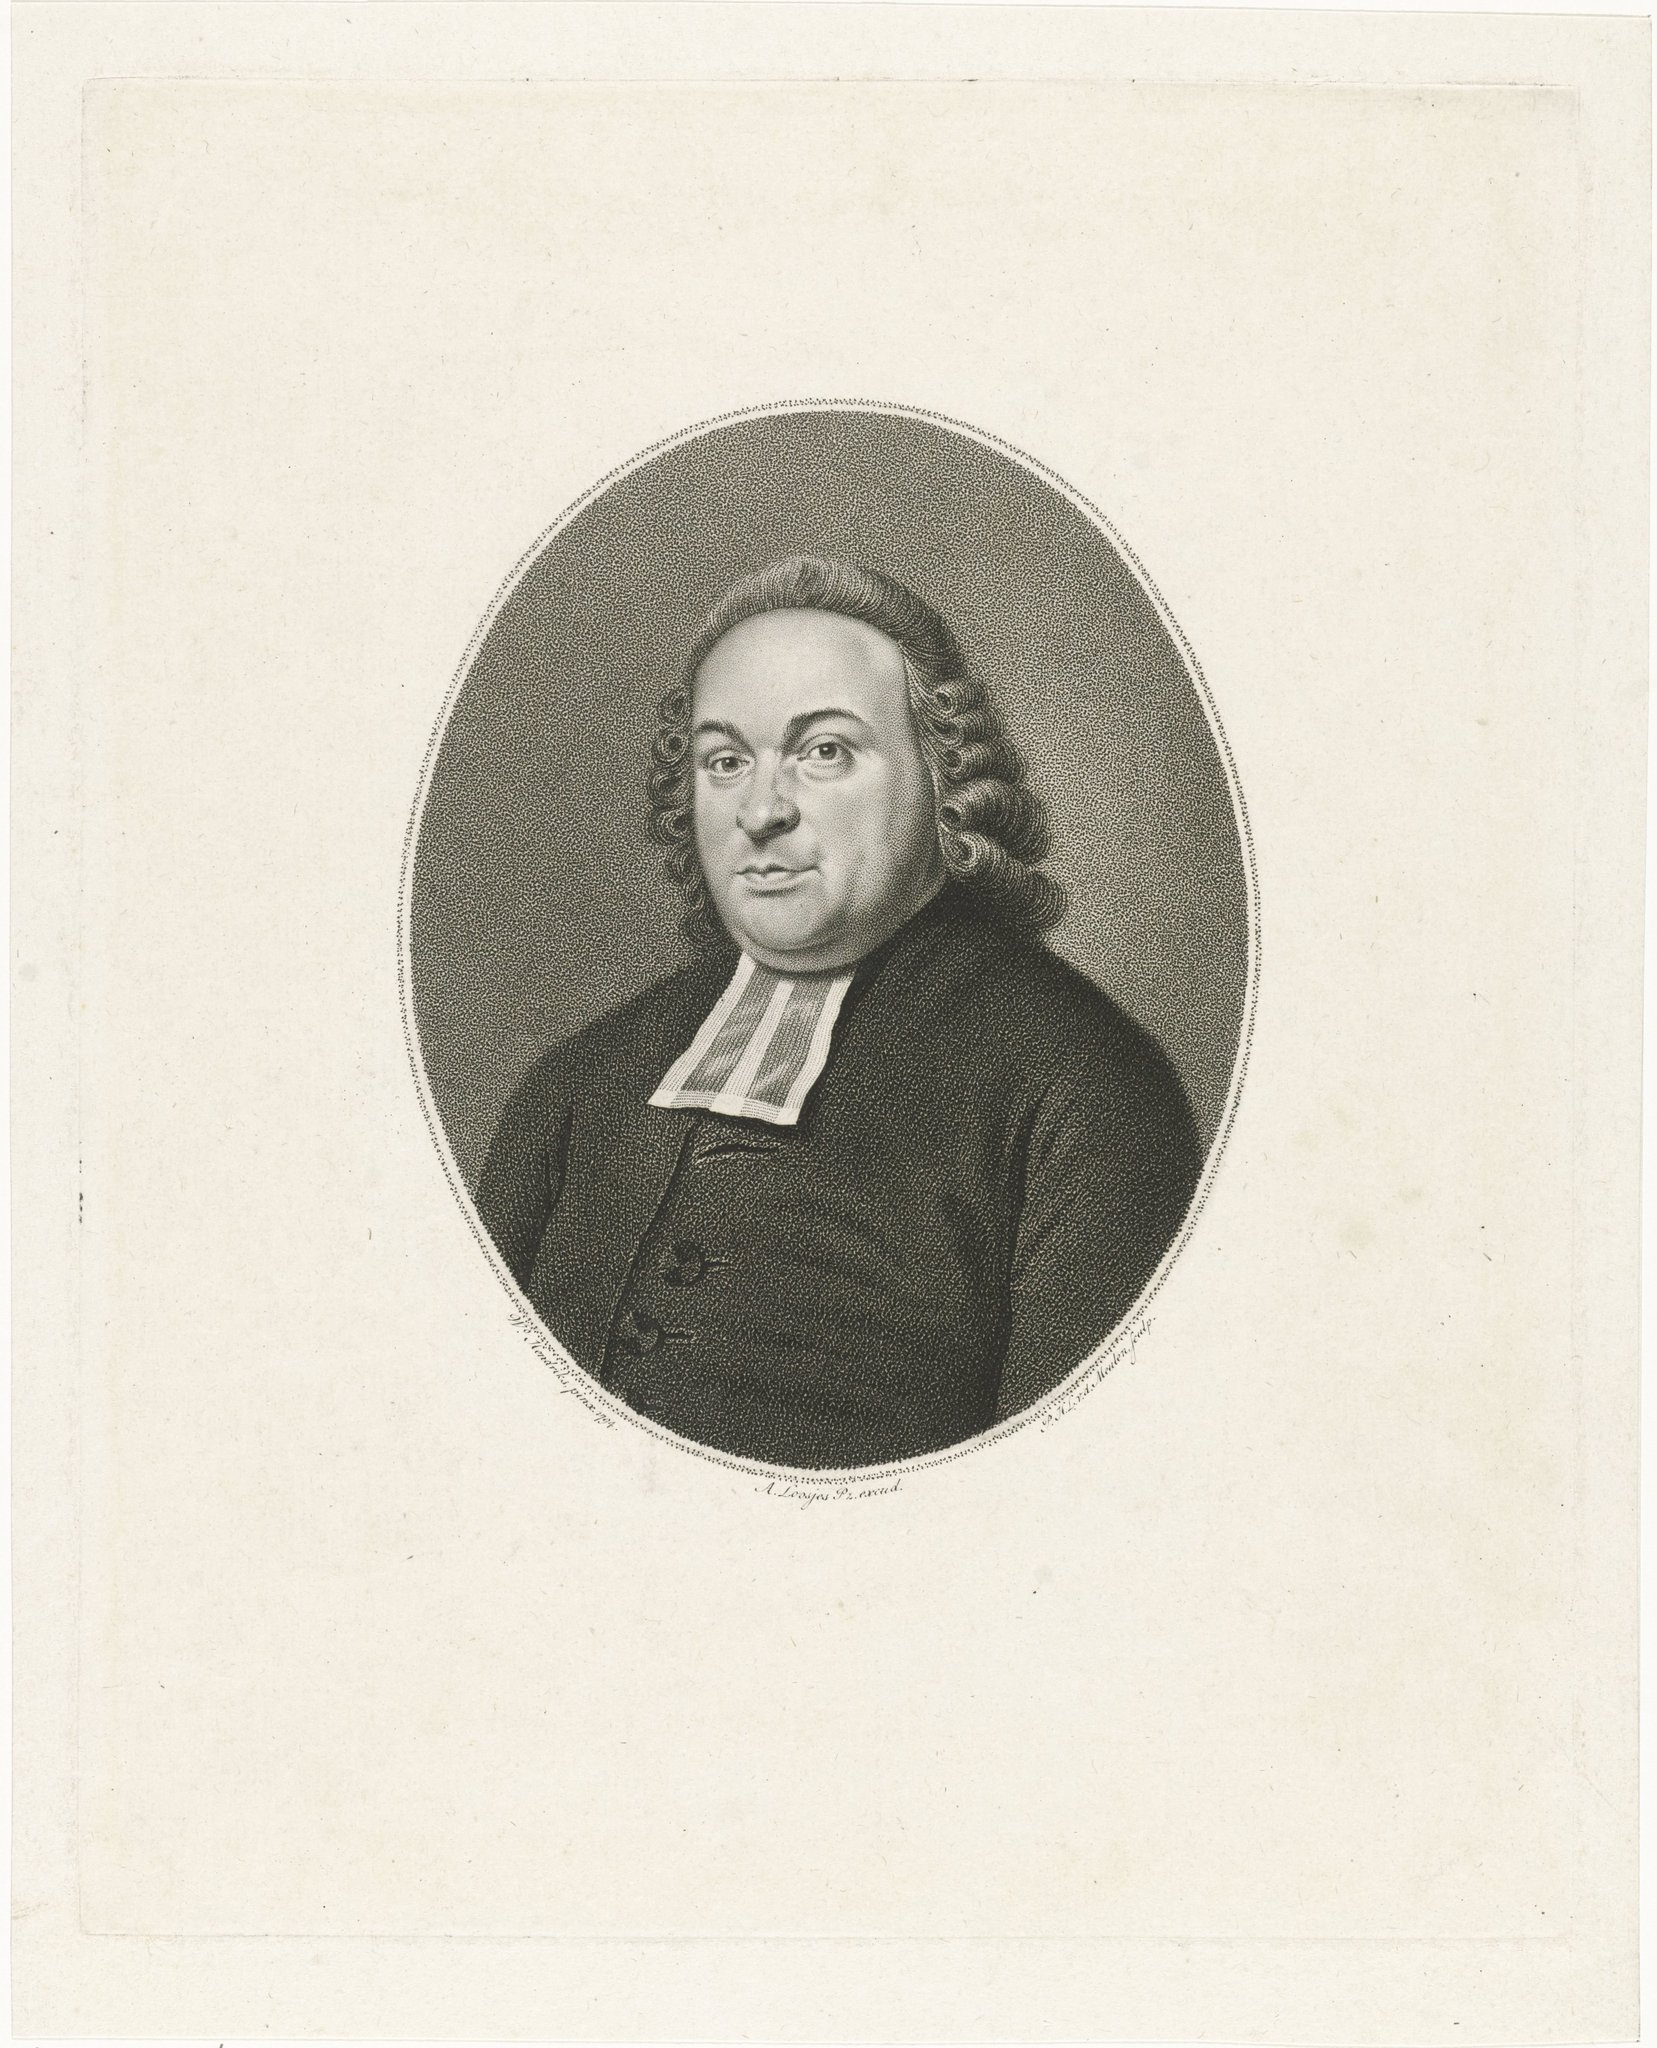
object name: print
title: Portret van Abraham Rutgers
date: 1809-1811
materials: paper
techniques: stippled etching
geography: haarlem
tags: aalsmeer, abraham rutgers (1751-1809)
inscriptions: collector's mark: Lugt 2228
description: Portret van Abraham Rutgers, predikant te Haarlem.